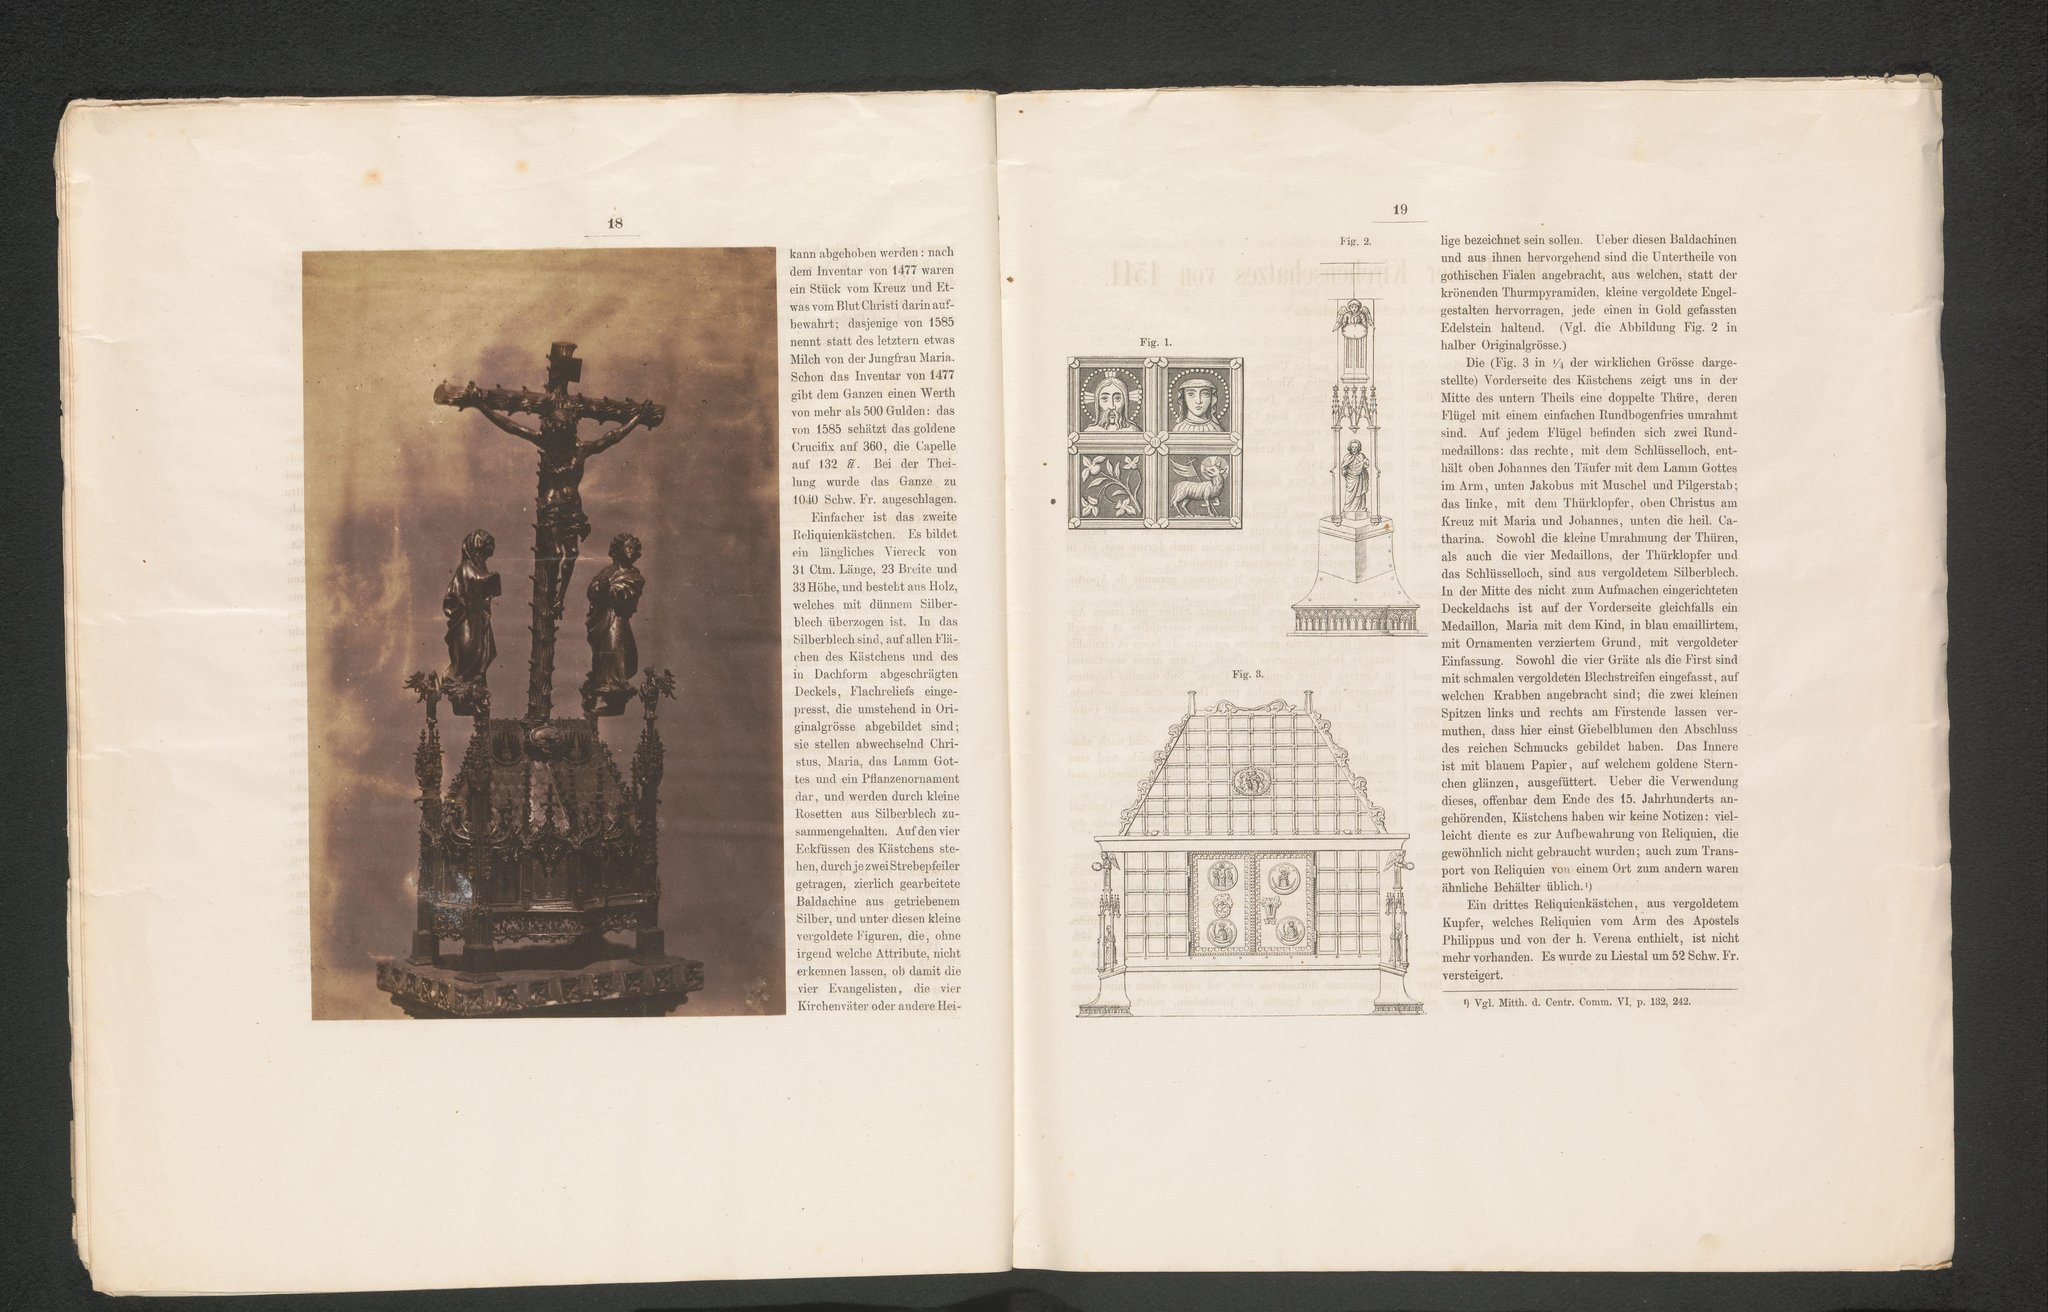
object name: photograph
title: Relikwieënkast met Christus aan het kruis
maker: jakob höflinger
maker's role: fotograaf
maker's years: 1819-1892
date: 1857-1862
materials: photographic support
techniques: albumen print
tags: relics (and reliquaries), the crucifixion of christ: christ's death on the cross; golgotha (matthew 27:45-58; mark 15:33-45; luke 23:44-52; john 19:25-38)